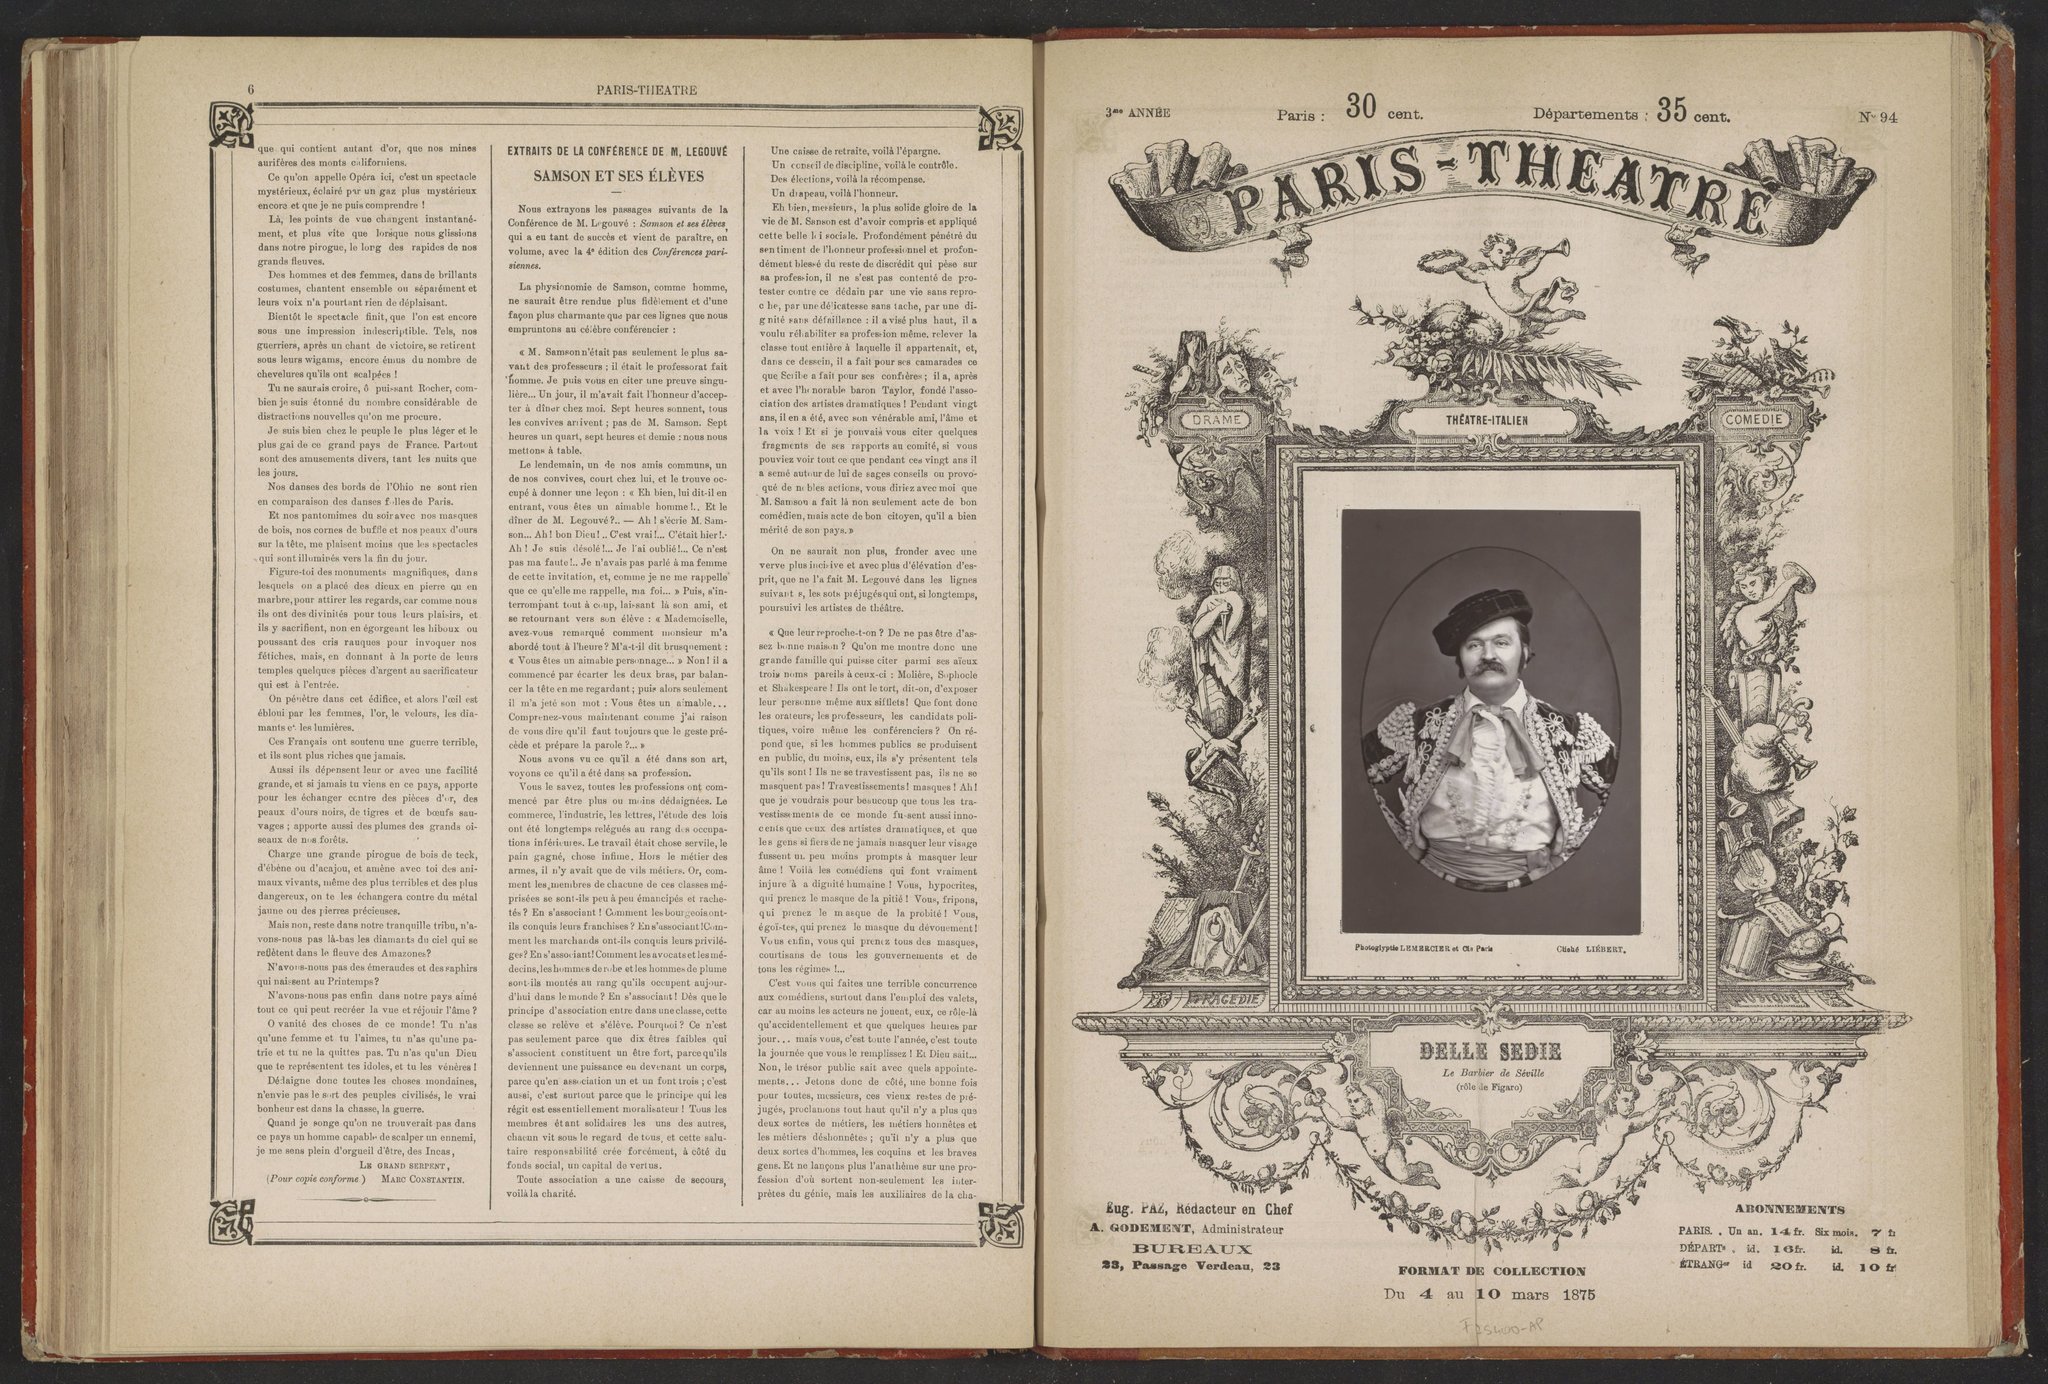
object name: photomechanical print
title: Delle Sedie Le Barbier de Séville (rôle de Figaro)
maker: alphonse-justin liébert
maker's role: fotograaf, marinier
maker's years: 1827-1914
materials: paper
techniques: woodburytype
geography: paris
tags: portrait of opera-singer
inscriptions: number: ‘No 94’, inscription: ‘Du 4 au 10 mars 1875’